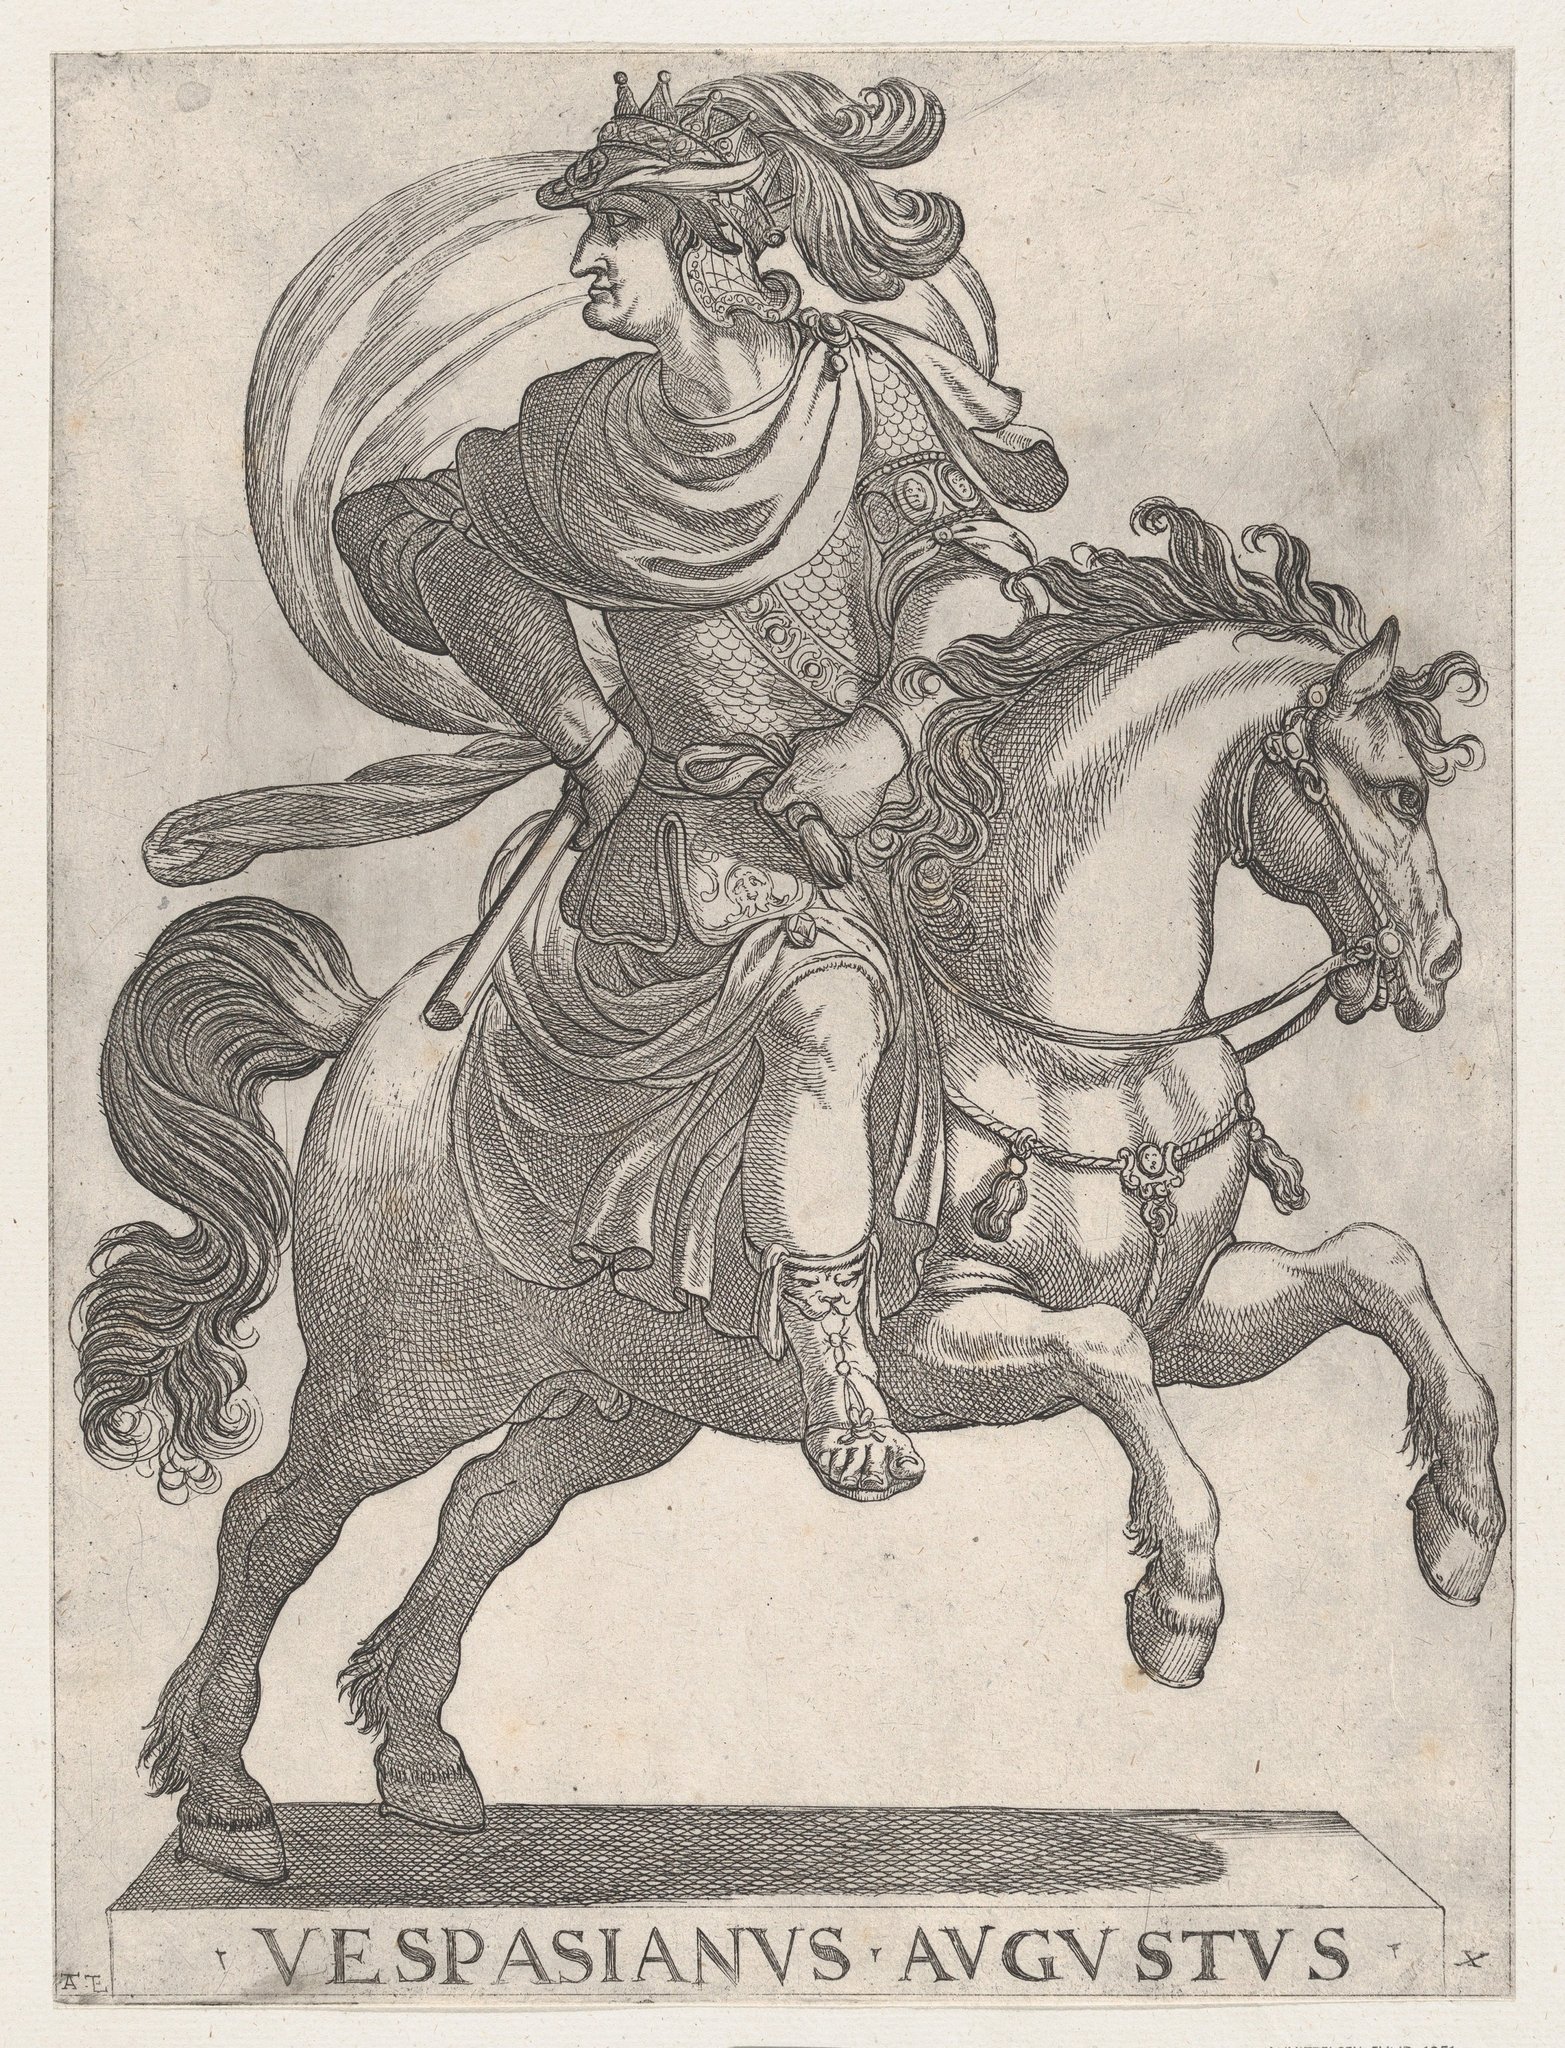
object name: print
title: Emperor Vespasian on Horseback, from the series The First Twelve Roman Caesars, plate 10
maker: antonio tempesta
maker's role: artist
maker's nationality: italian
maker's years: 1555-1630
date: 1596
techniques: etching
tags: men,horses